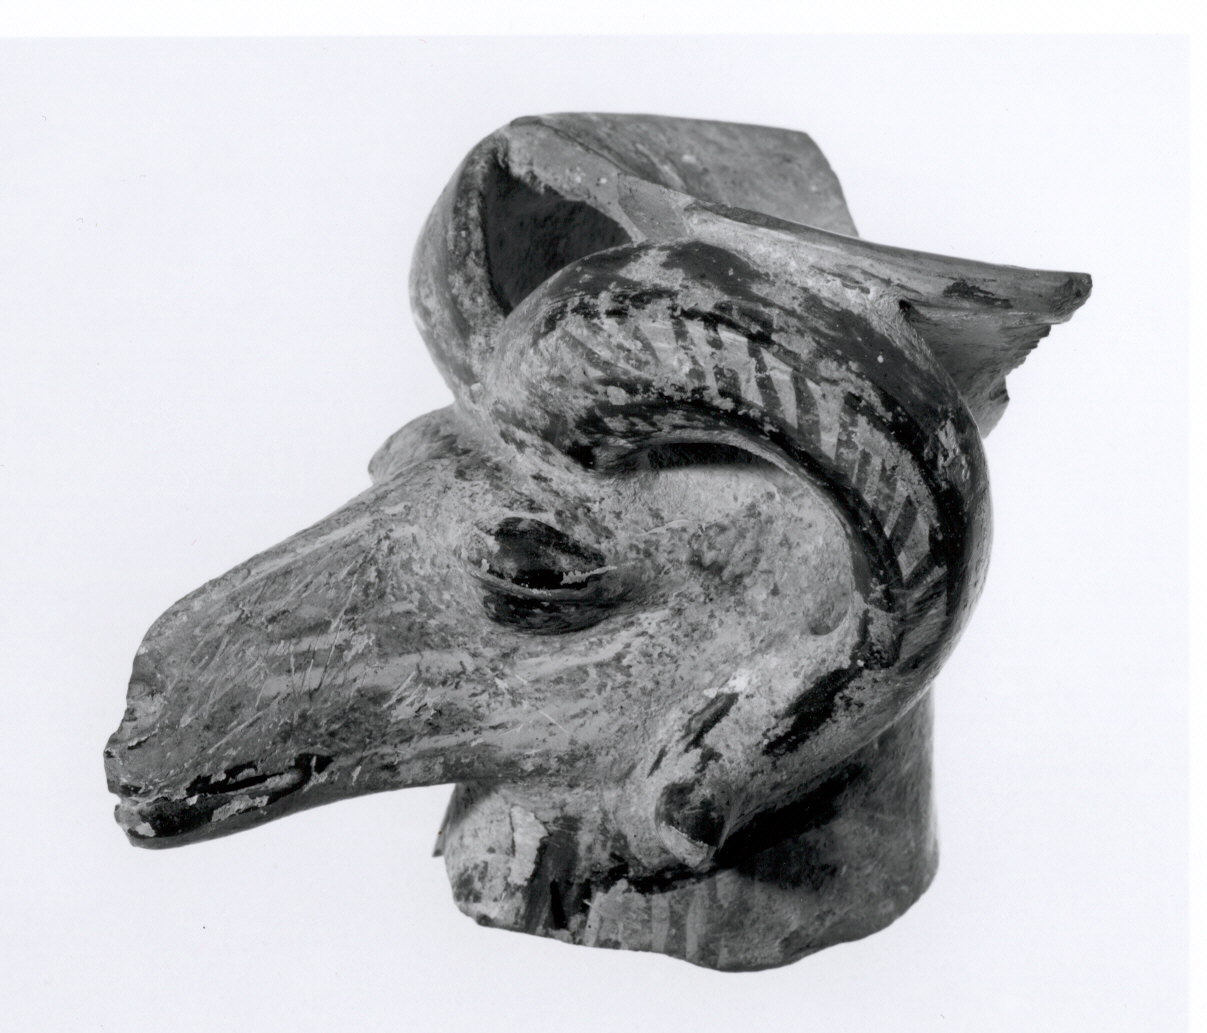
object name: rhyton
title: Fragment of a rhyton in the shape of a ram's head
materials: ceramic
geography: anatolia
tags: rams